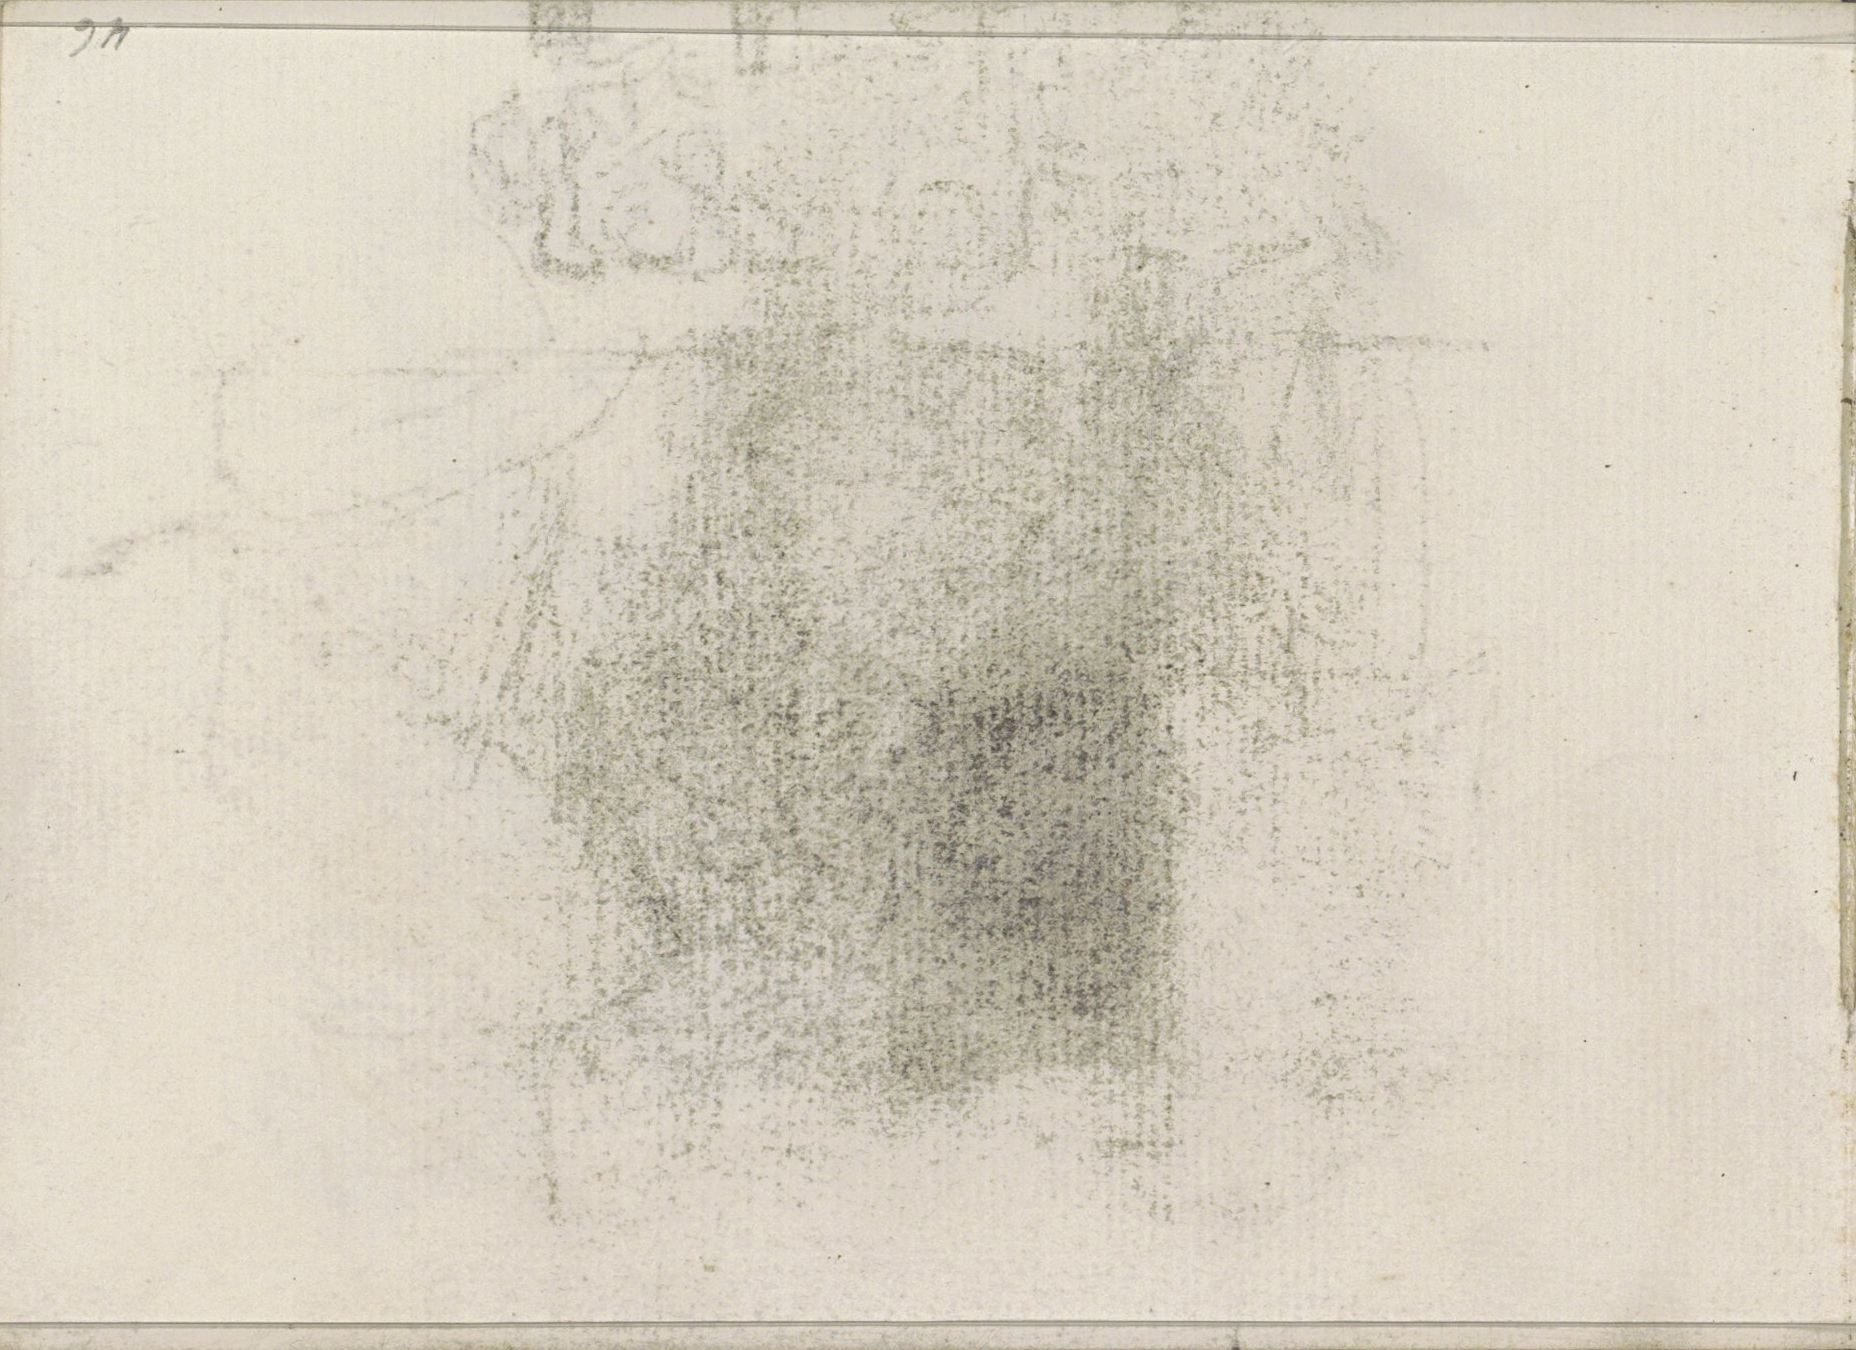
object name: sketchbook leaf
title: Abklatsch van de krijttekening op blad 8 recto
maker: isaac israels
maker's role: draughtsman, painter, print maker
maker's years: 1865-1934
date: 1875-1934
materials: paper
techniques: printmaking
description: Blad 7 verso uit schetsboek LVI met 26 bladen.